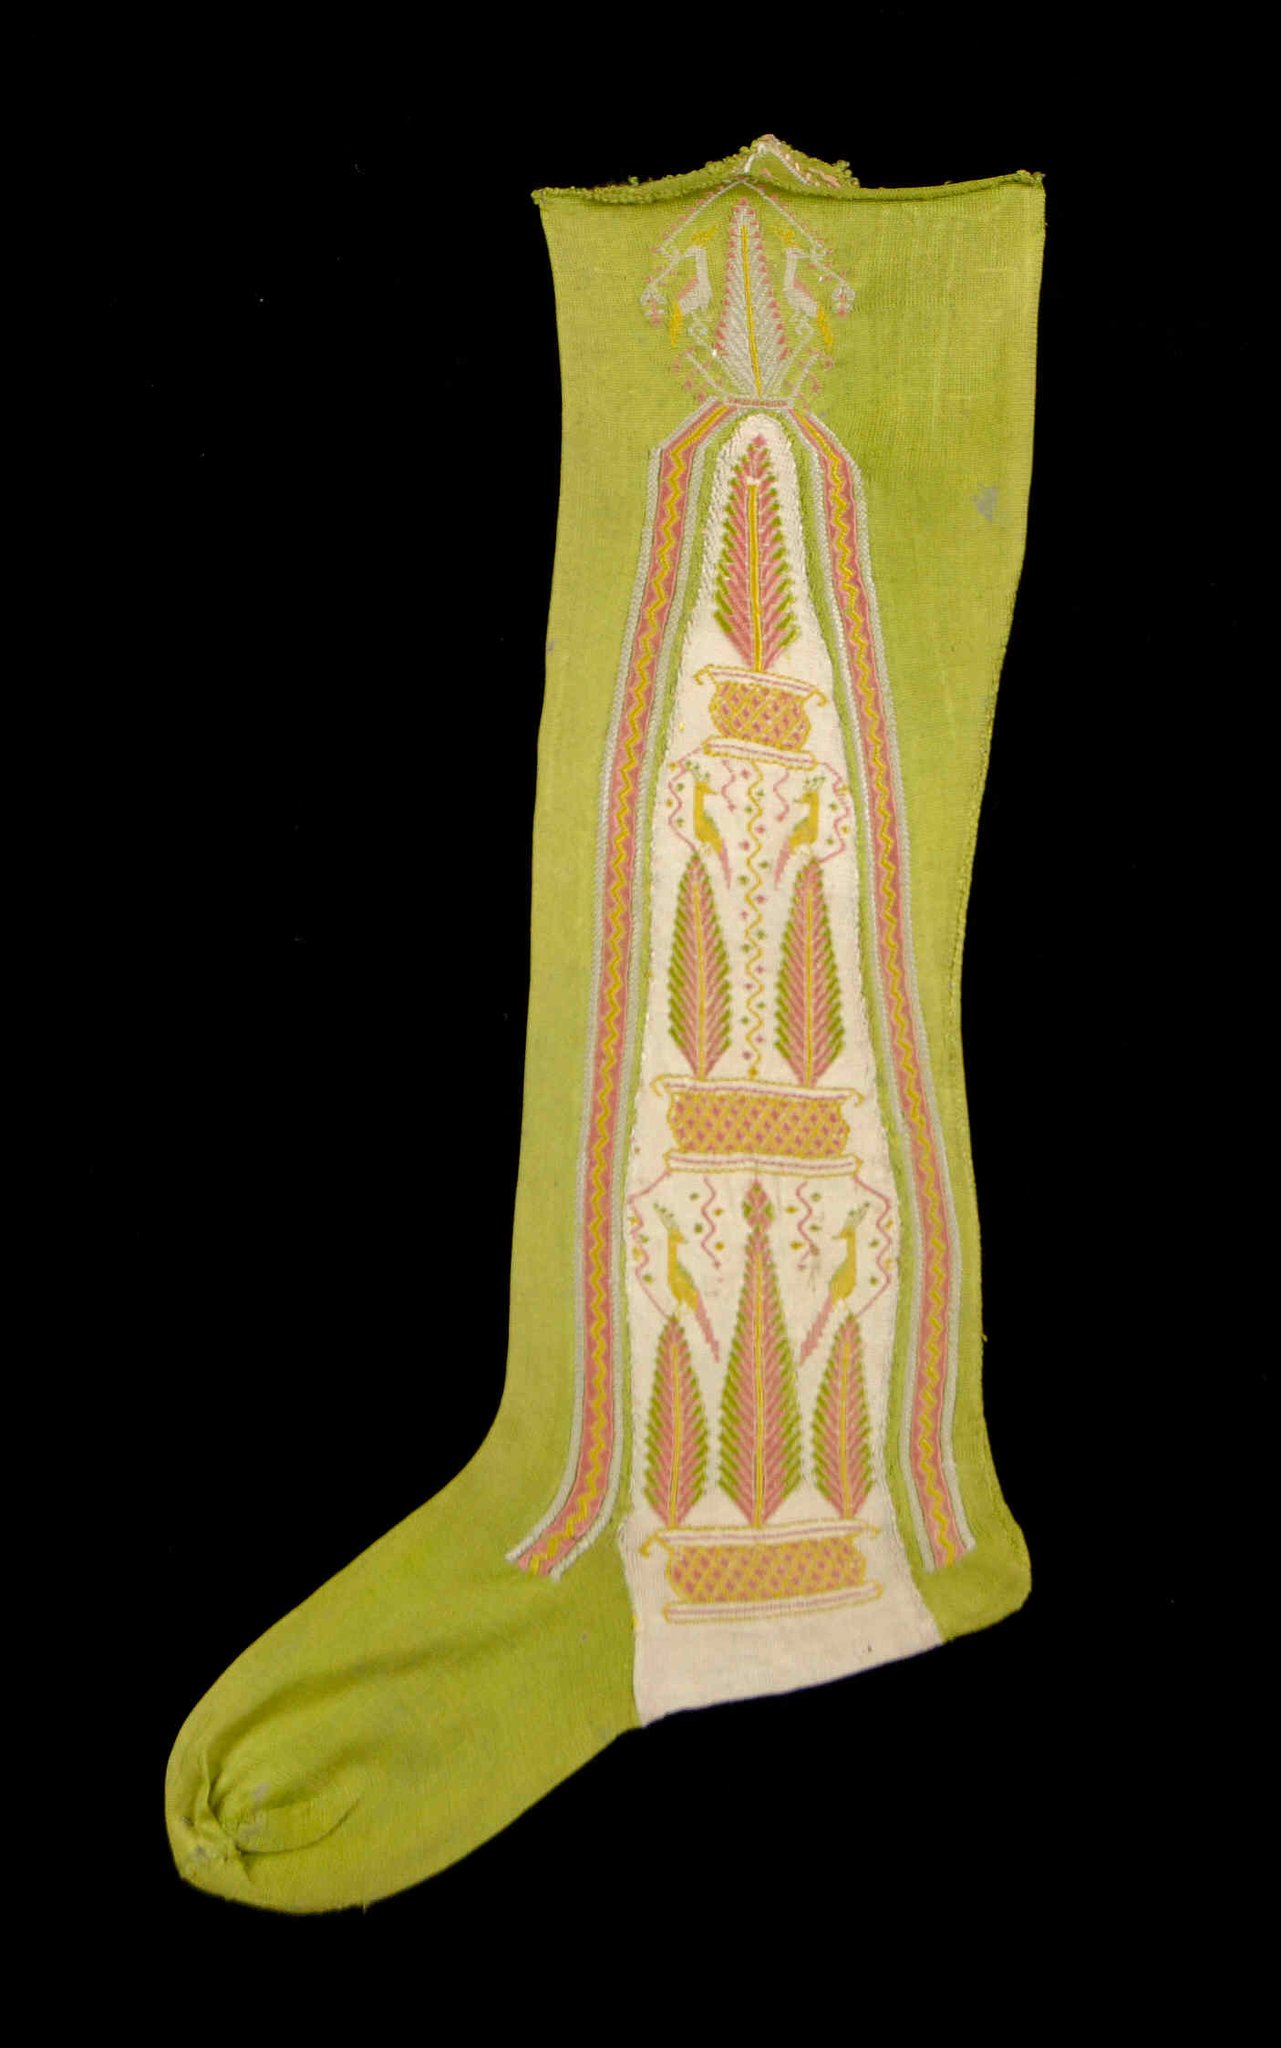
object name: stocking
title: Stockings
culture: british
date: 1801-1825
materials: silk